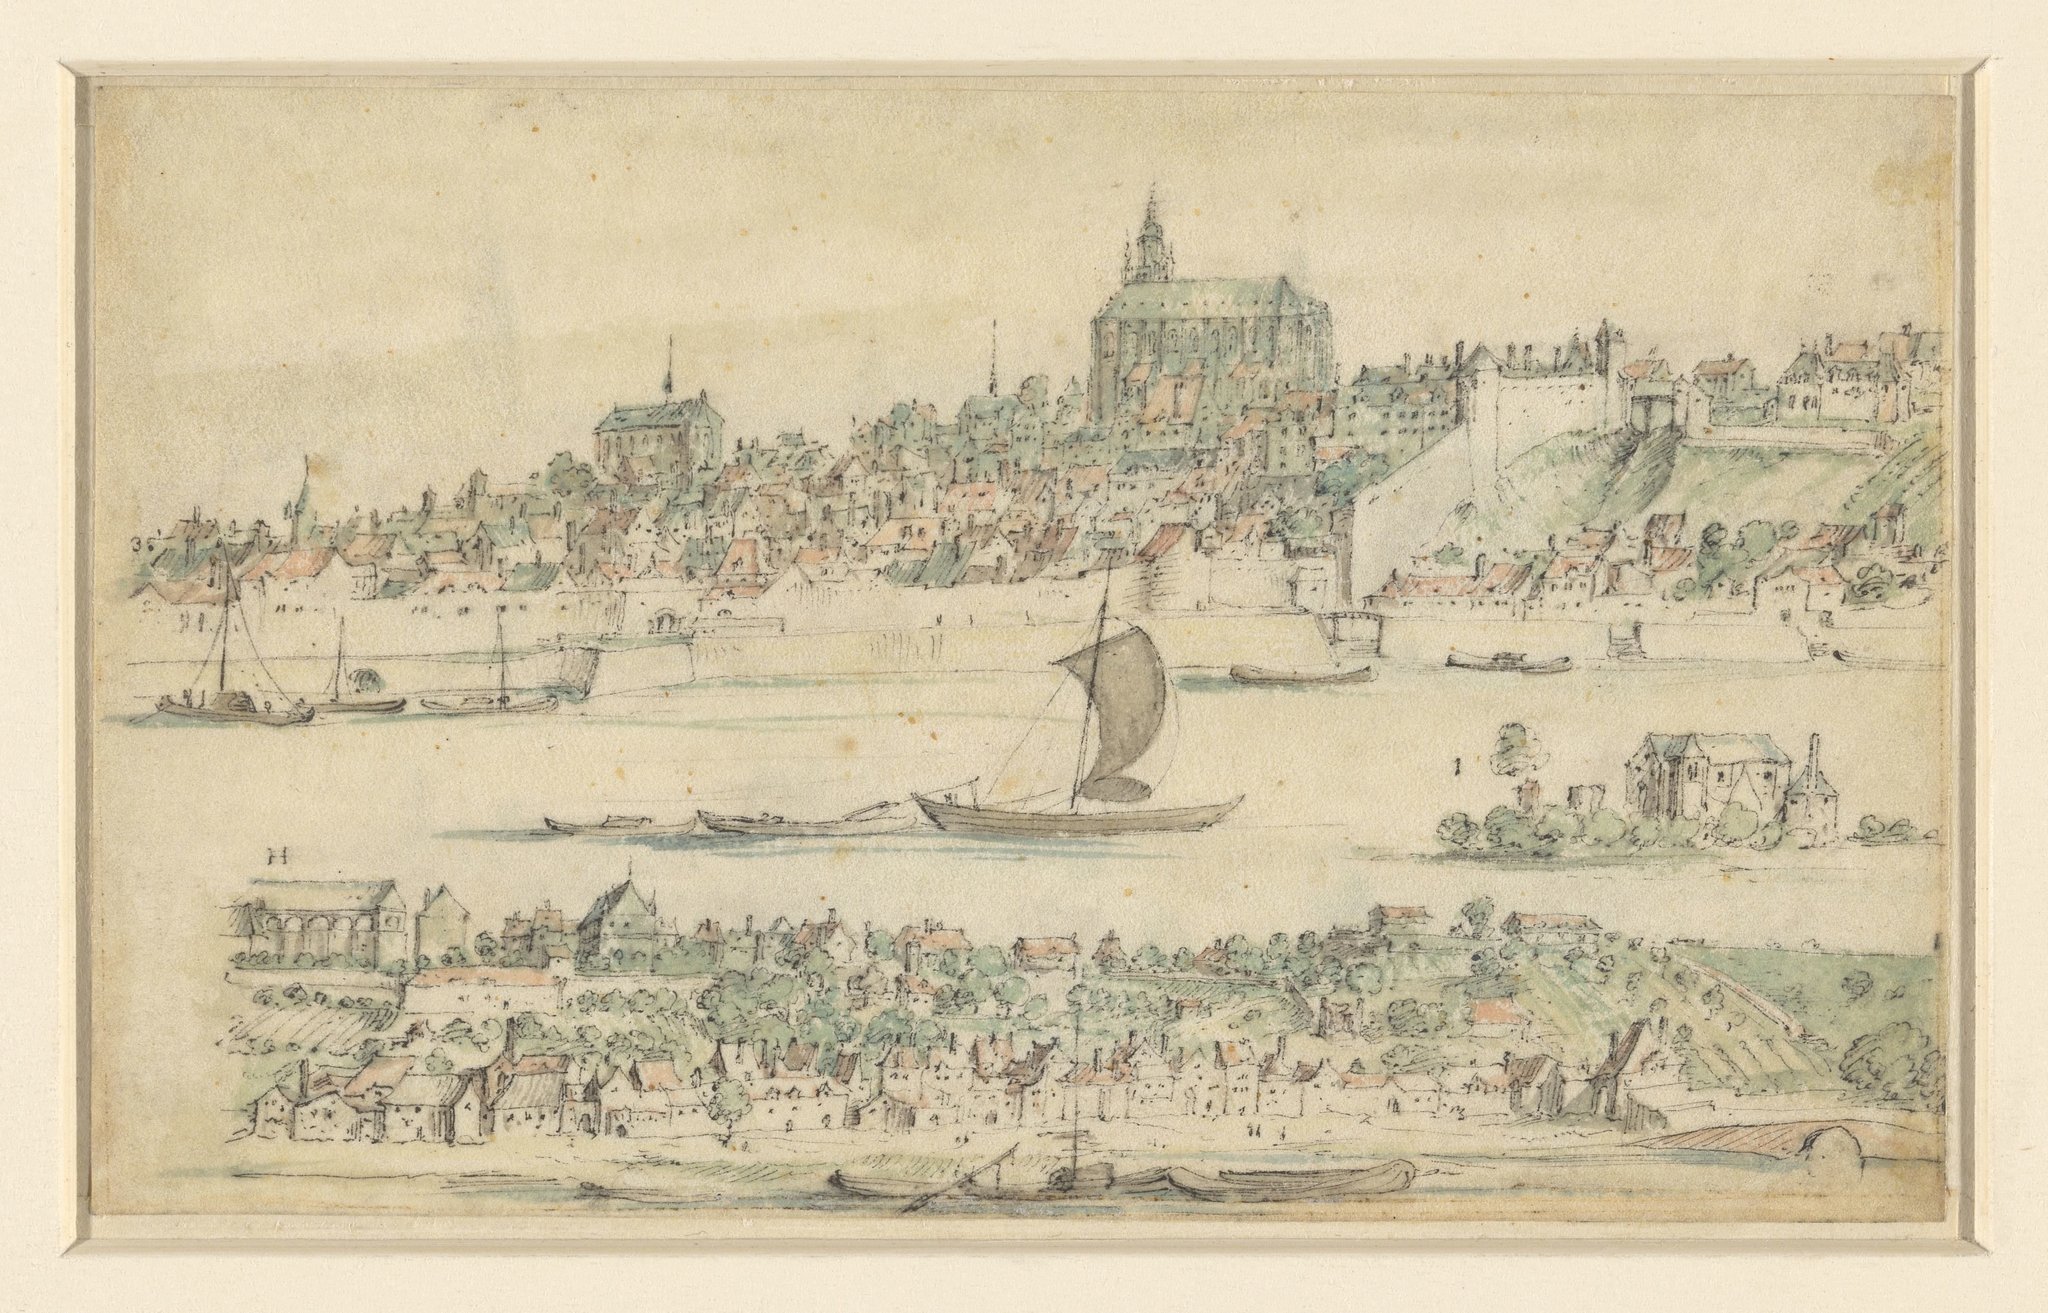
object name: drawing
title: Stad aan de Loire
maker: Anonymous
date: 1600-1650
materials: ink, parchment, watercolor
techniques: brush, pen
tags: city-view in general; 'veduta' (+ city(-scape) with figures, staffage), canals, waters (in city) (+ city(-scape) with figures, staffage)